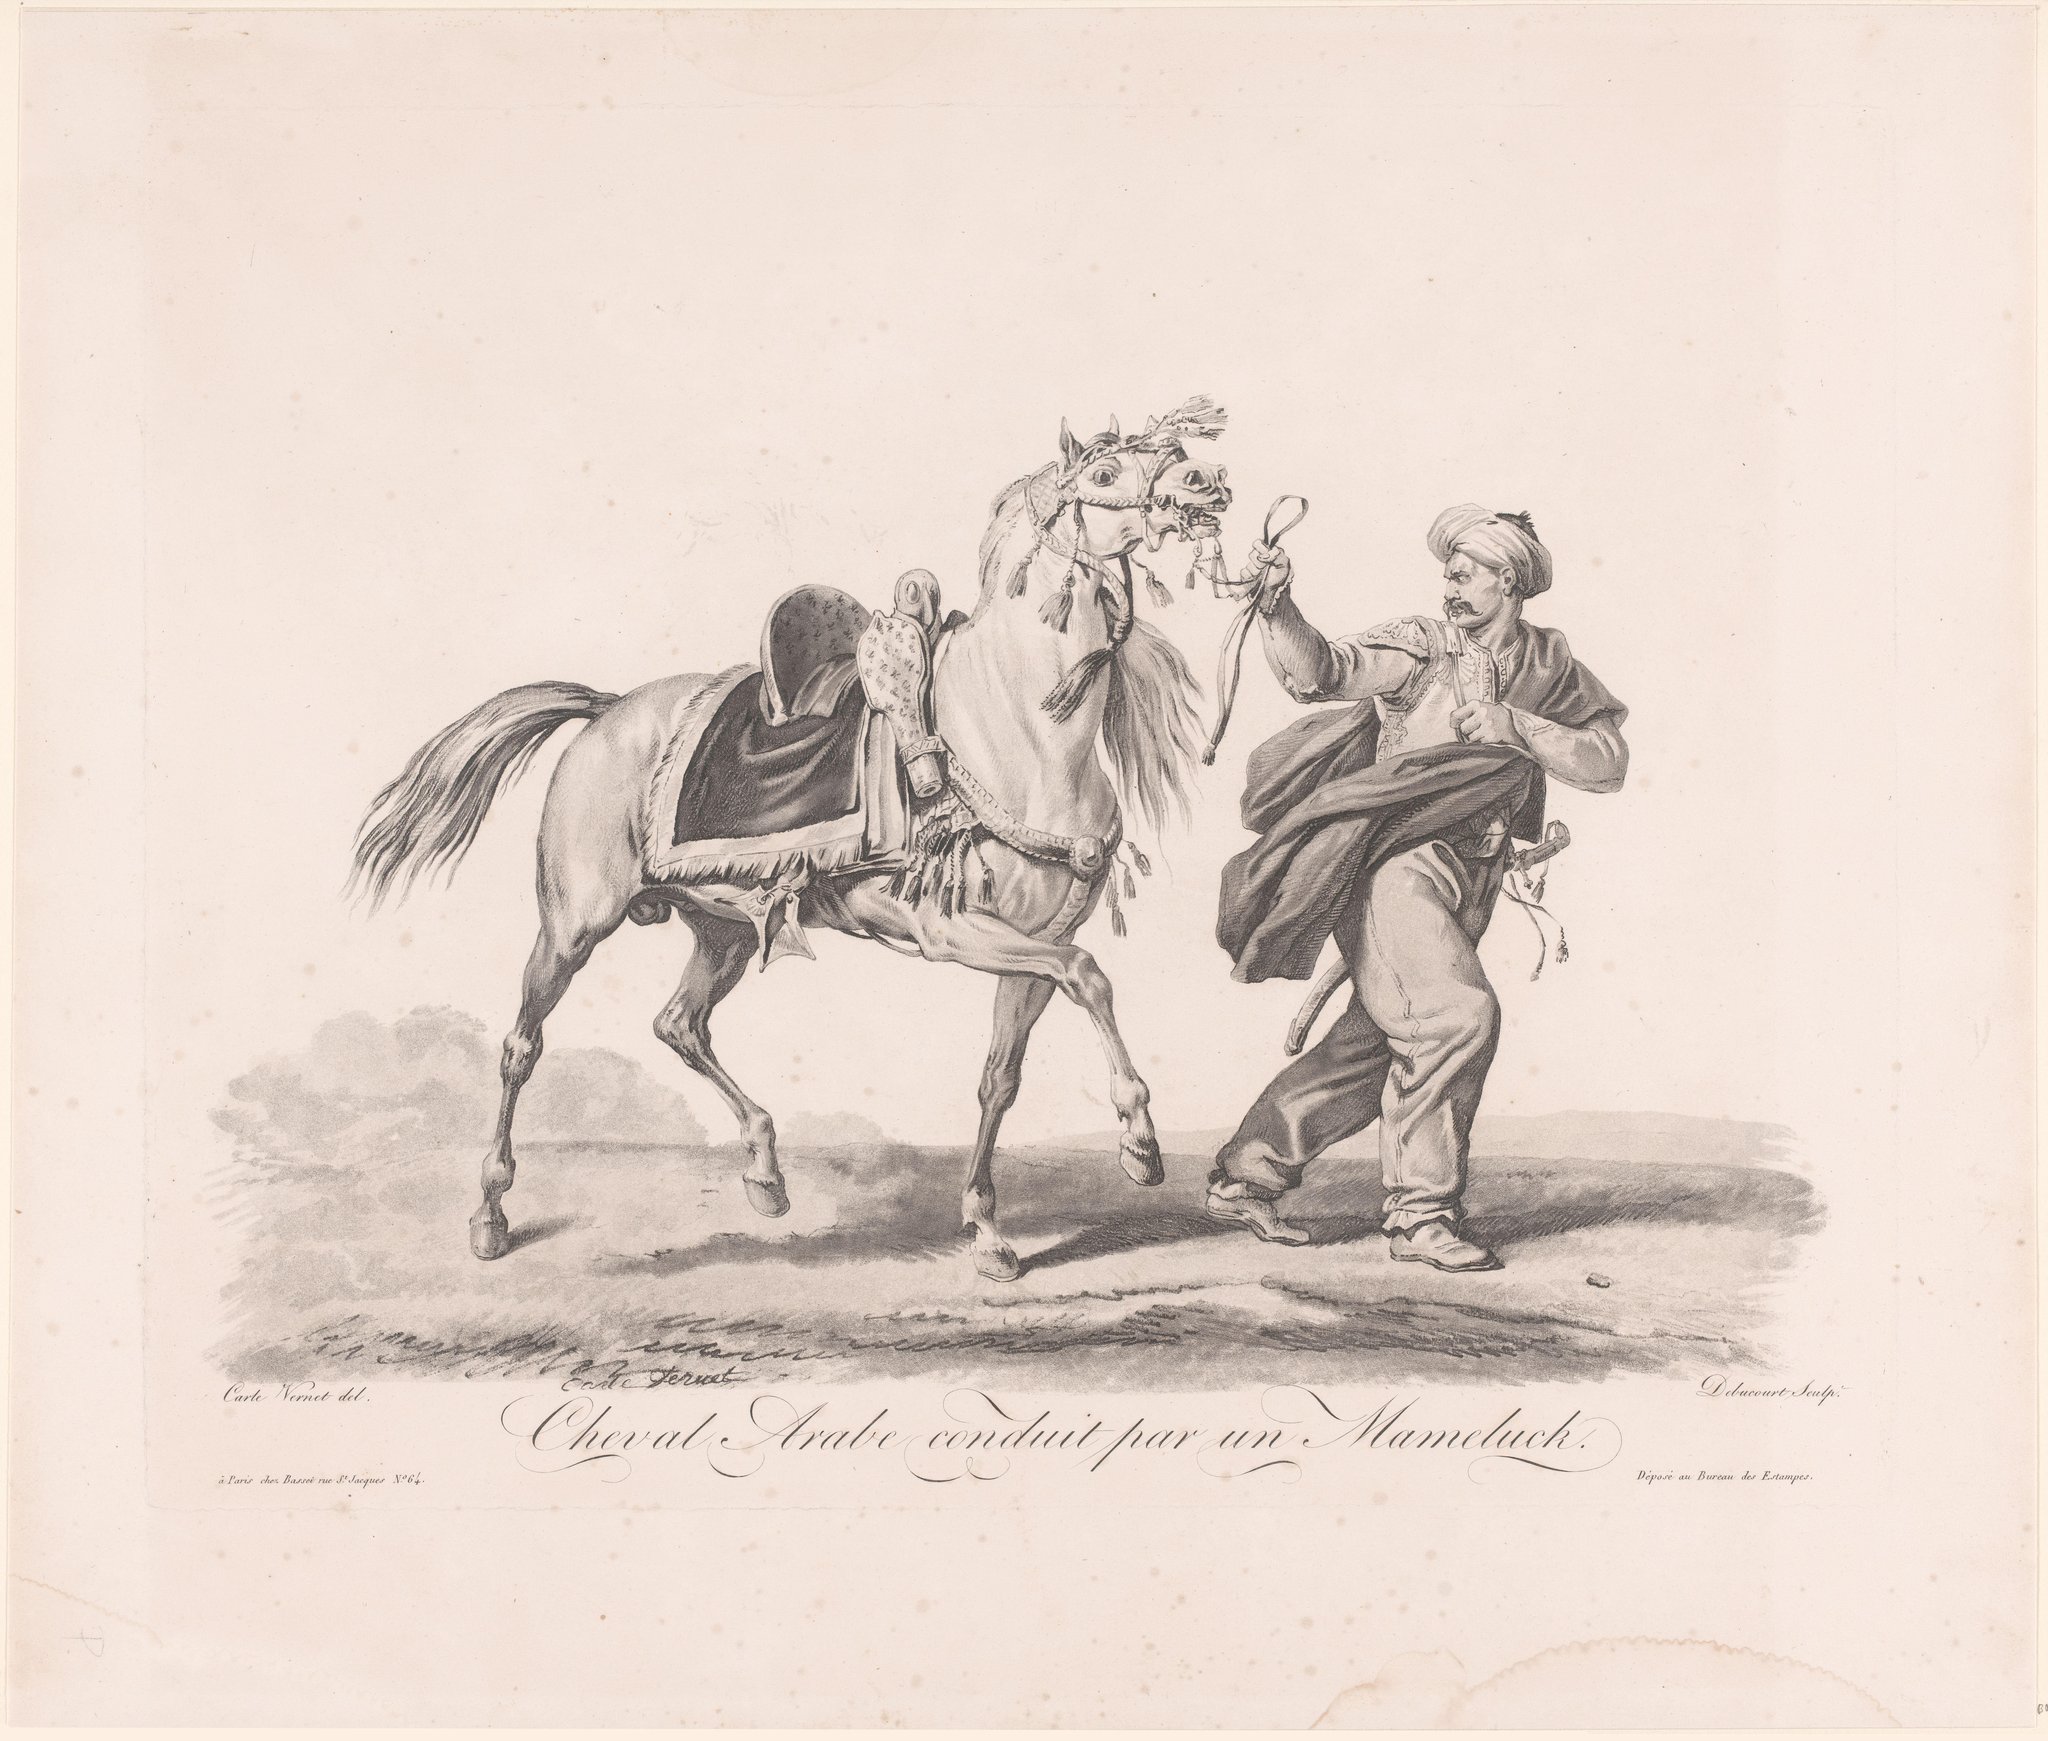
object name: print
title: Paard bij de teugels geleid door Oosterse man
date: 1765-1832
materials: paper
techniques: aquatint, etching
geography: paris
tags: leading a horse by the reins; rider beside his horse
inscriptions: collector's mark: Lugt 2228